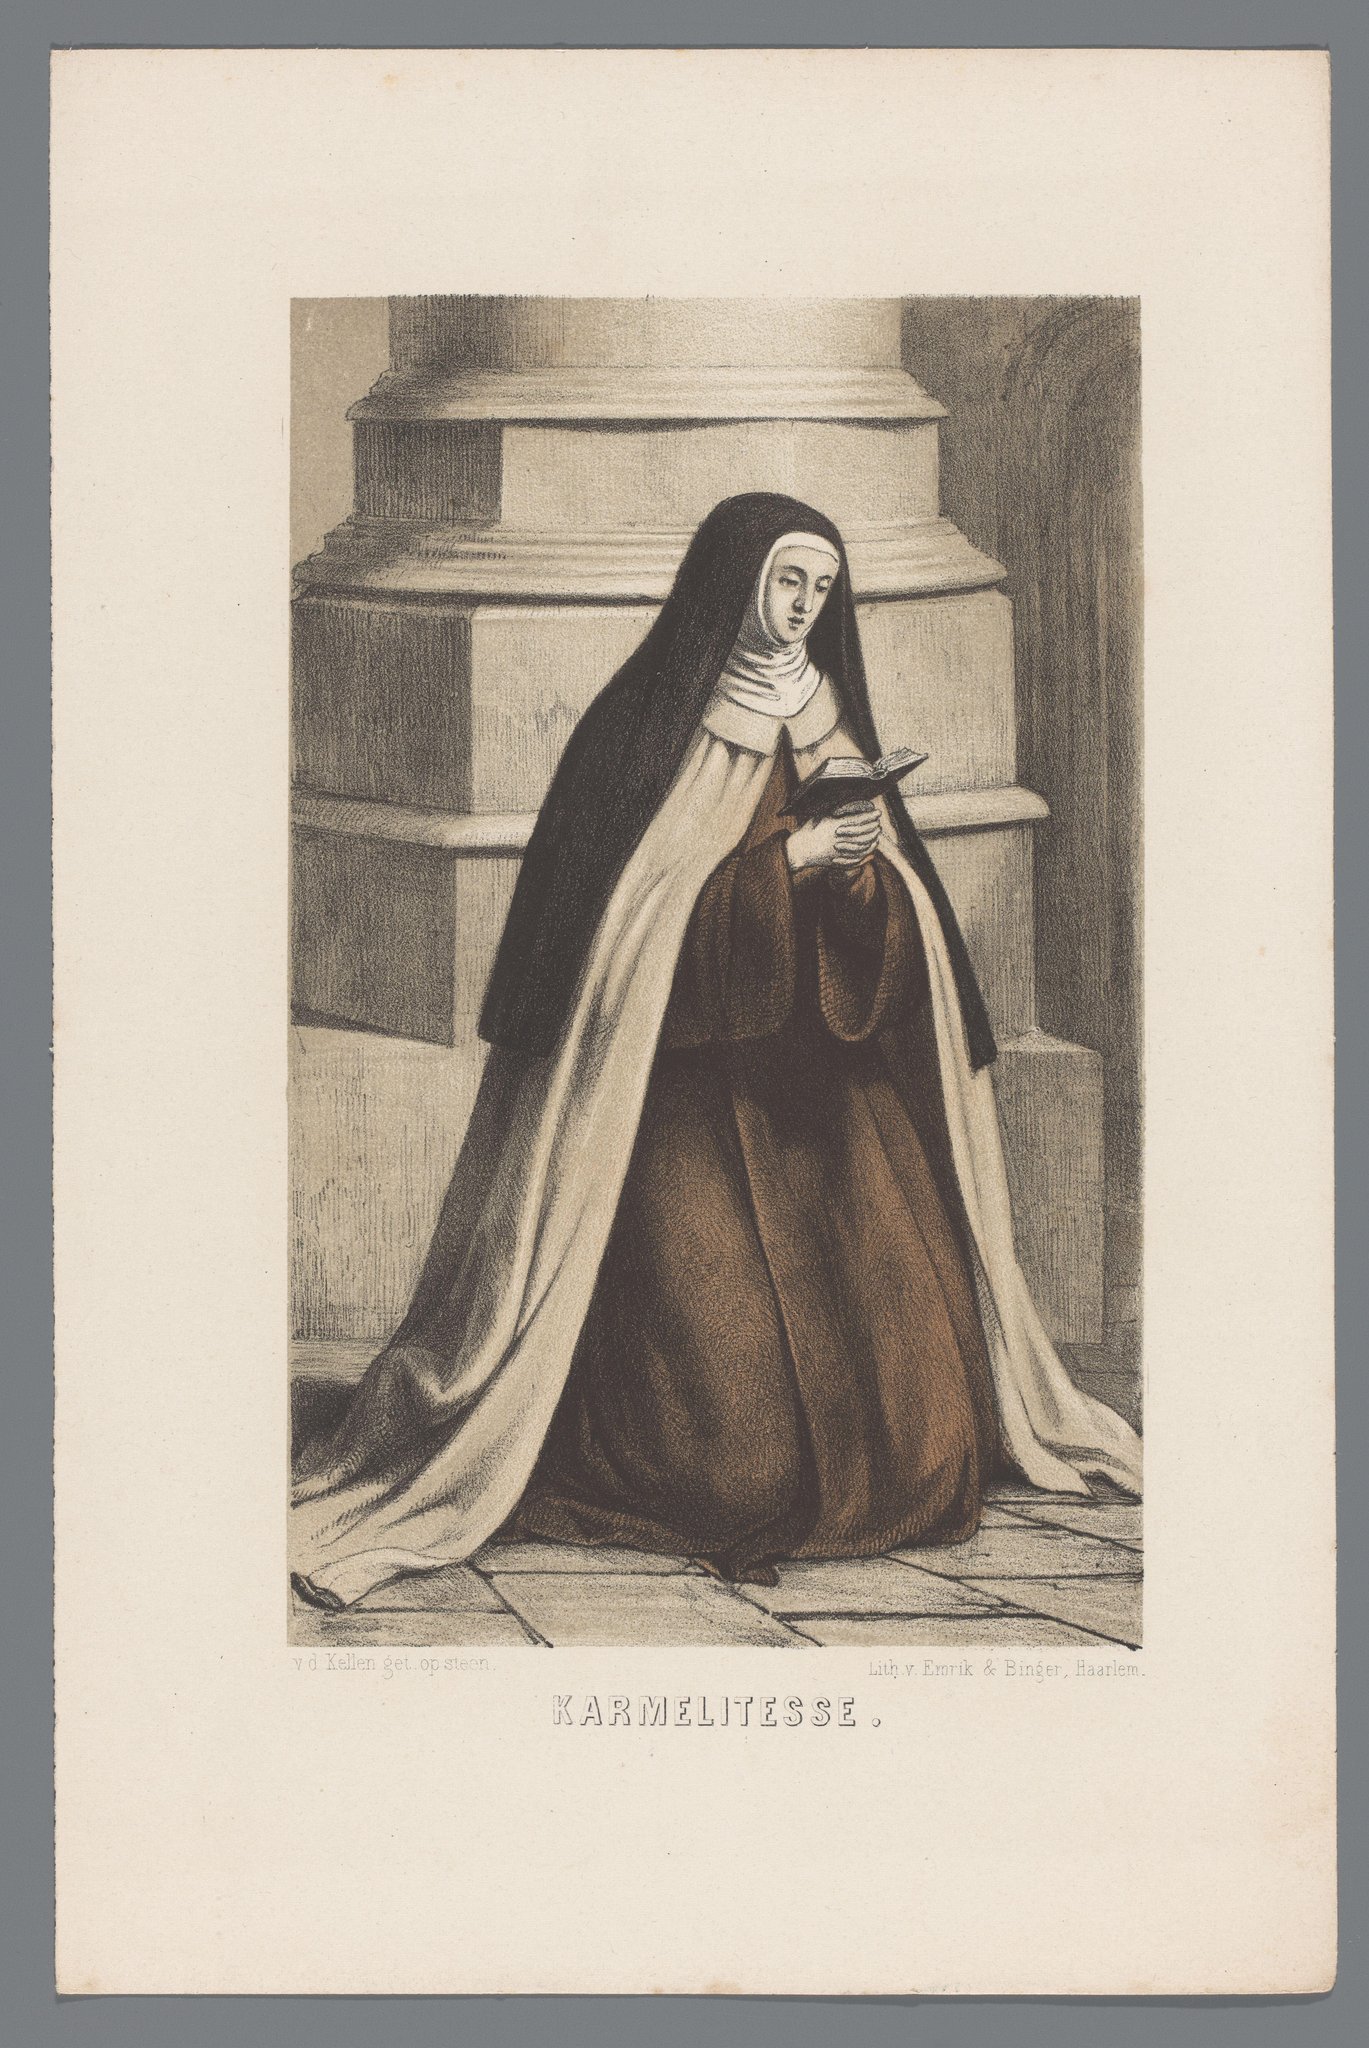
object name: book illustration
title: Lezende non van de Orde van de Karmelieten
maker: david van der kellen (1827-1895)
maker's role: draughtsman, print maker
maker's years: 1827-1895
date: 1865-1874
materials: paper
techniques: tone lithography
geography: haarlem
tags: nun(s), reading the bible or other religious books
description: Prent waarschijnlijk uit: Hofdijk, W.J. De klooster-orden in Nederland. Haarlem: A.C. Kruseman, 1865. Of uit de editie van 1874.